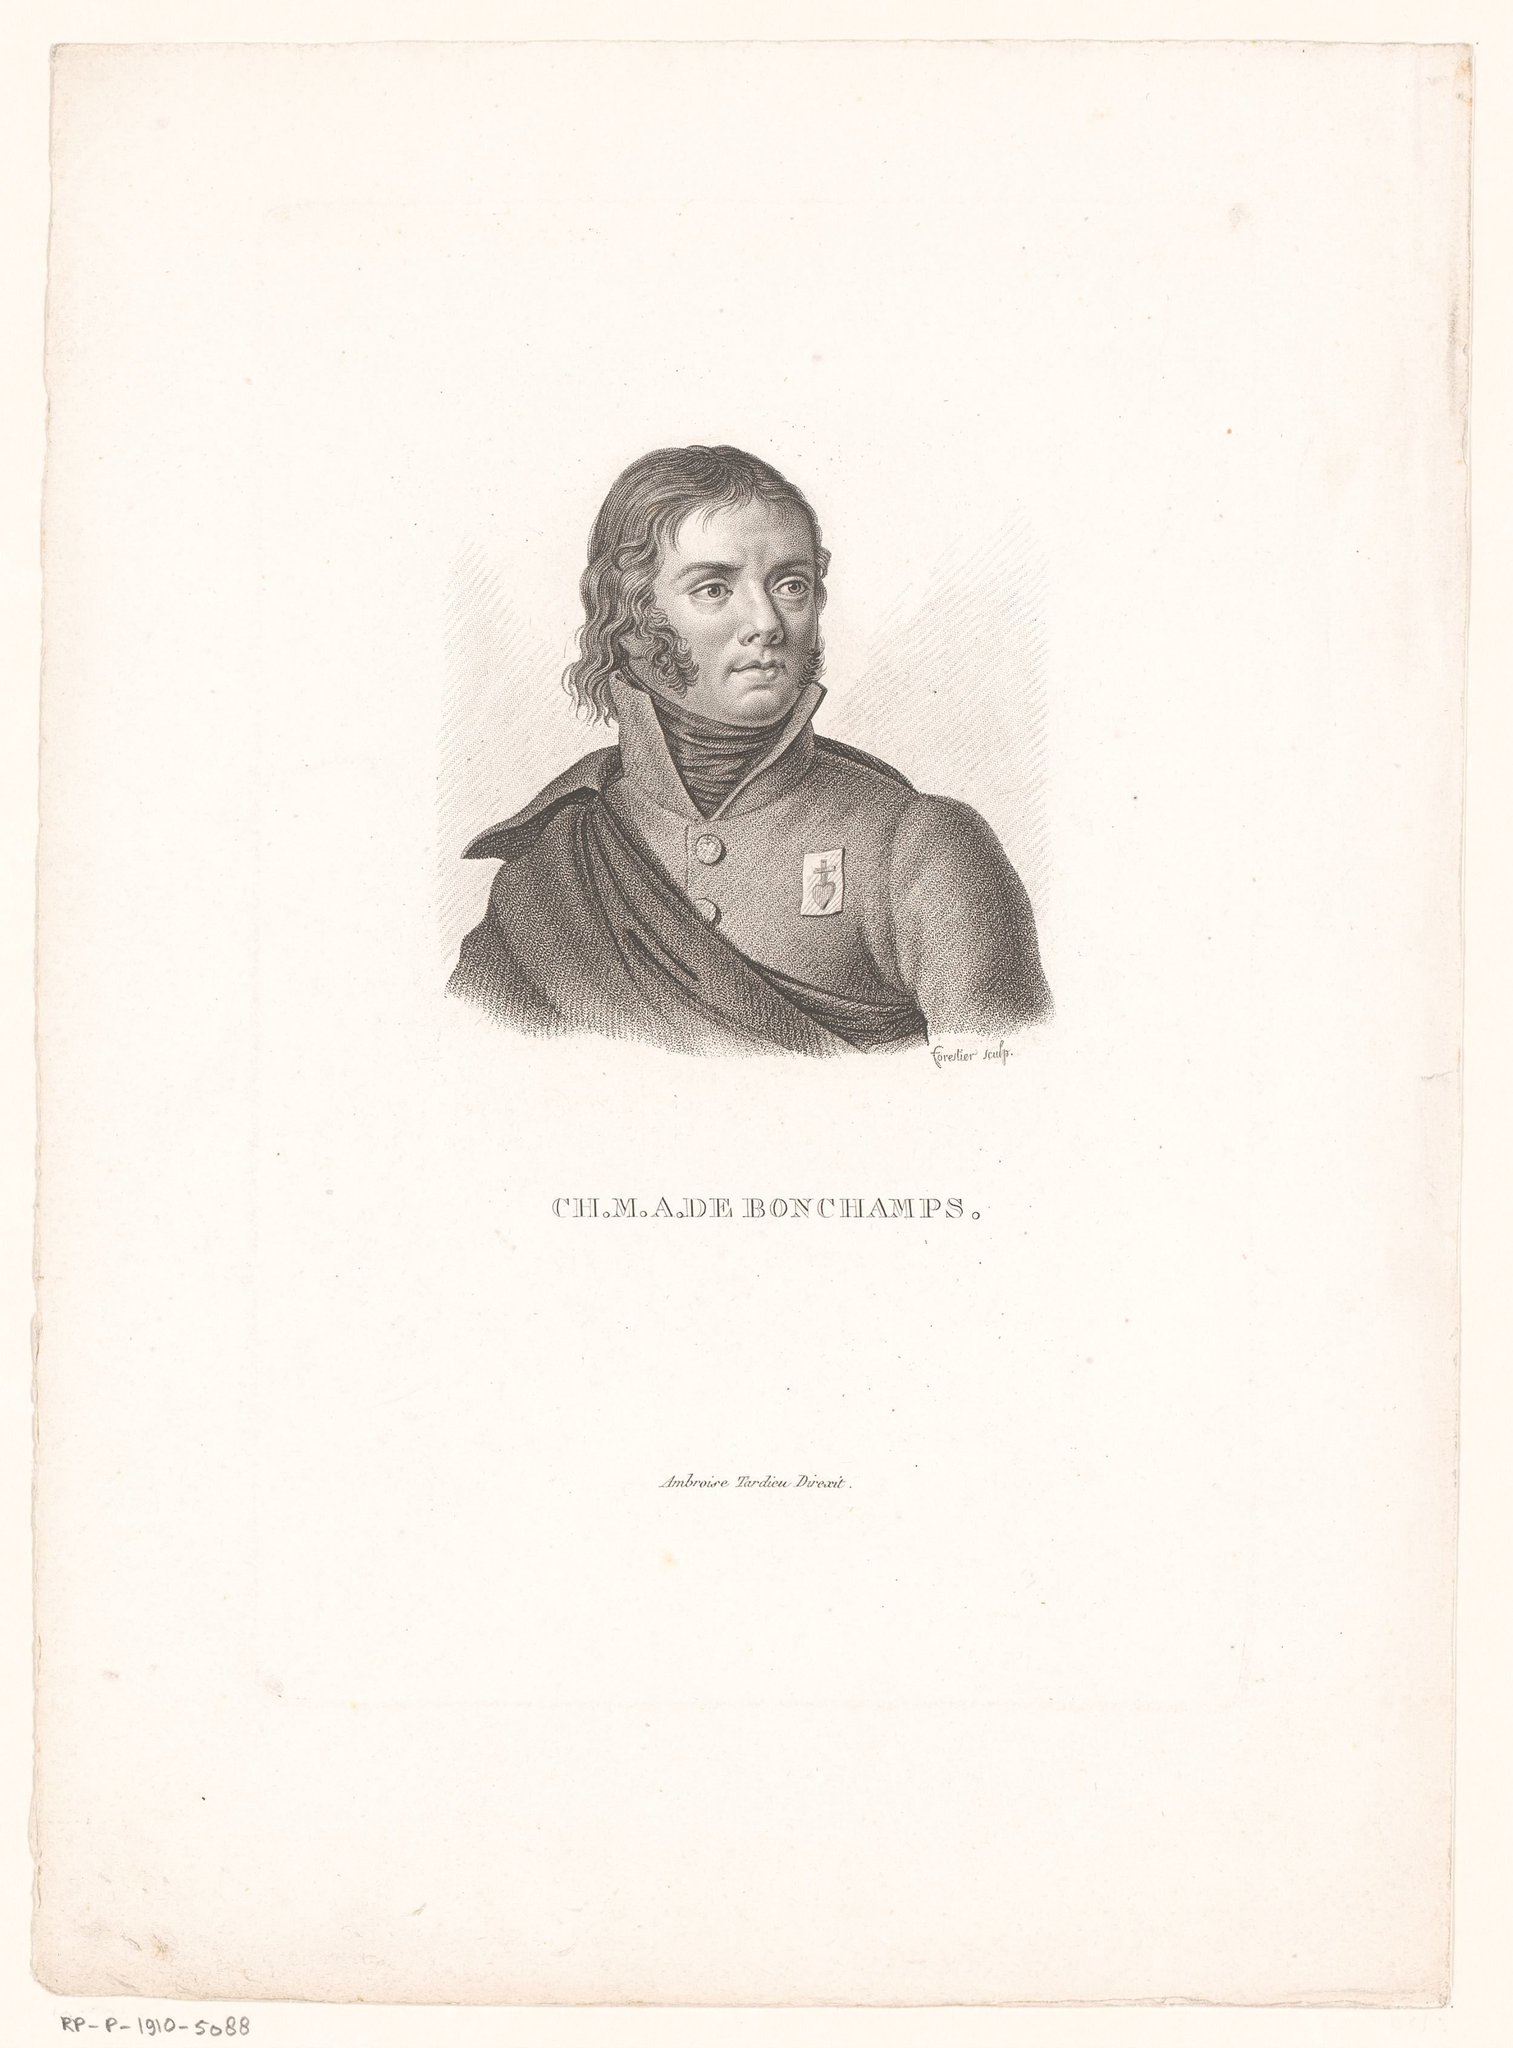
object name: book illustration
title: Portret van Charles de Bonchamps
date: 1818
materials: paper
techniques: engraving, roulette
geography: france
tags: politician, commander-in-chief, general, marshal, historical persons, politician, e.g. party leader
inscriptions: collector's mark: Lugt 2228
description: Mogelijk prent uit: Tardieu, Ambroise. Portraits des généraux français, faisant suite aux "Victoires et conquêtes des Français". Parijs: Panckoucke, Charles Louis Fleury, ca. 1818.